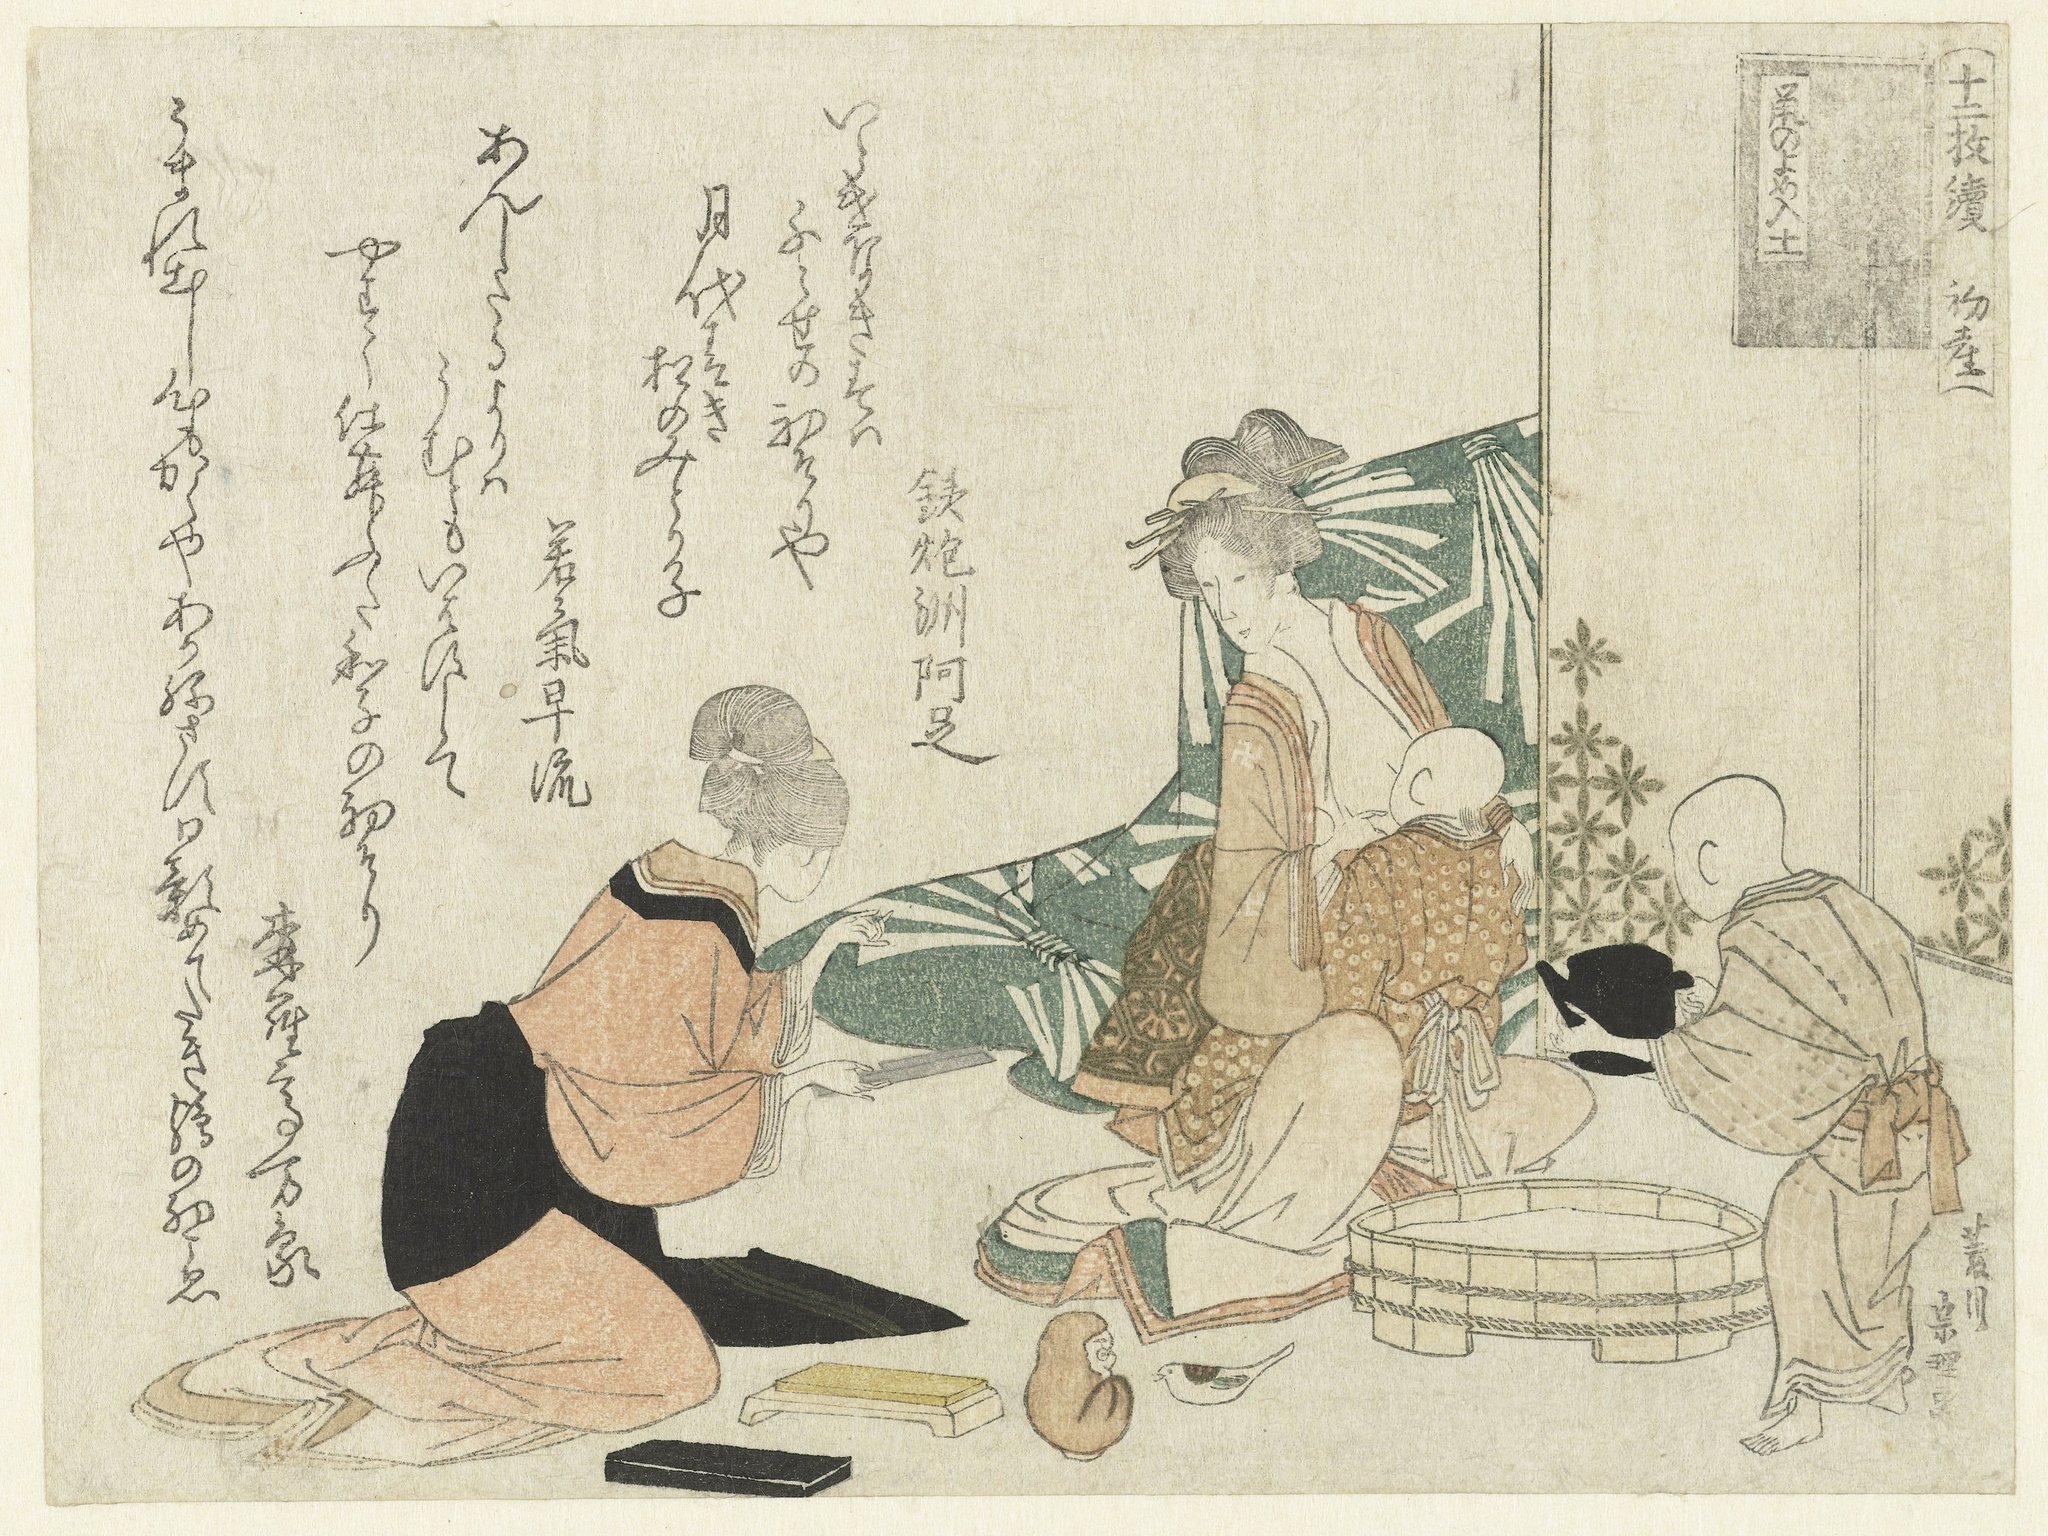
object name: print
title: Woman Feeding a Baby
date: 1804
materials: paper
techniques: blind stamped, woodcut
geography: japan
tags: nursing, suckling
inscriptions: stamp, verso, stamped: Paper crane.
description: Een surimono is een luxe uitgevoerde prent waarop beeld met één of meerdere gedichten gecombineerd is. Bij het drukken van een surimono werd vaak gebruik gemaakt van dikker papier, blinddruk en metaal pigmenten, zoals koper- en zilverpoeder. De prenten werden vaak in opdracht van dichters gemaakt en als exclusief geschenk aan vrienden en relaties gegeven.